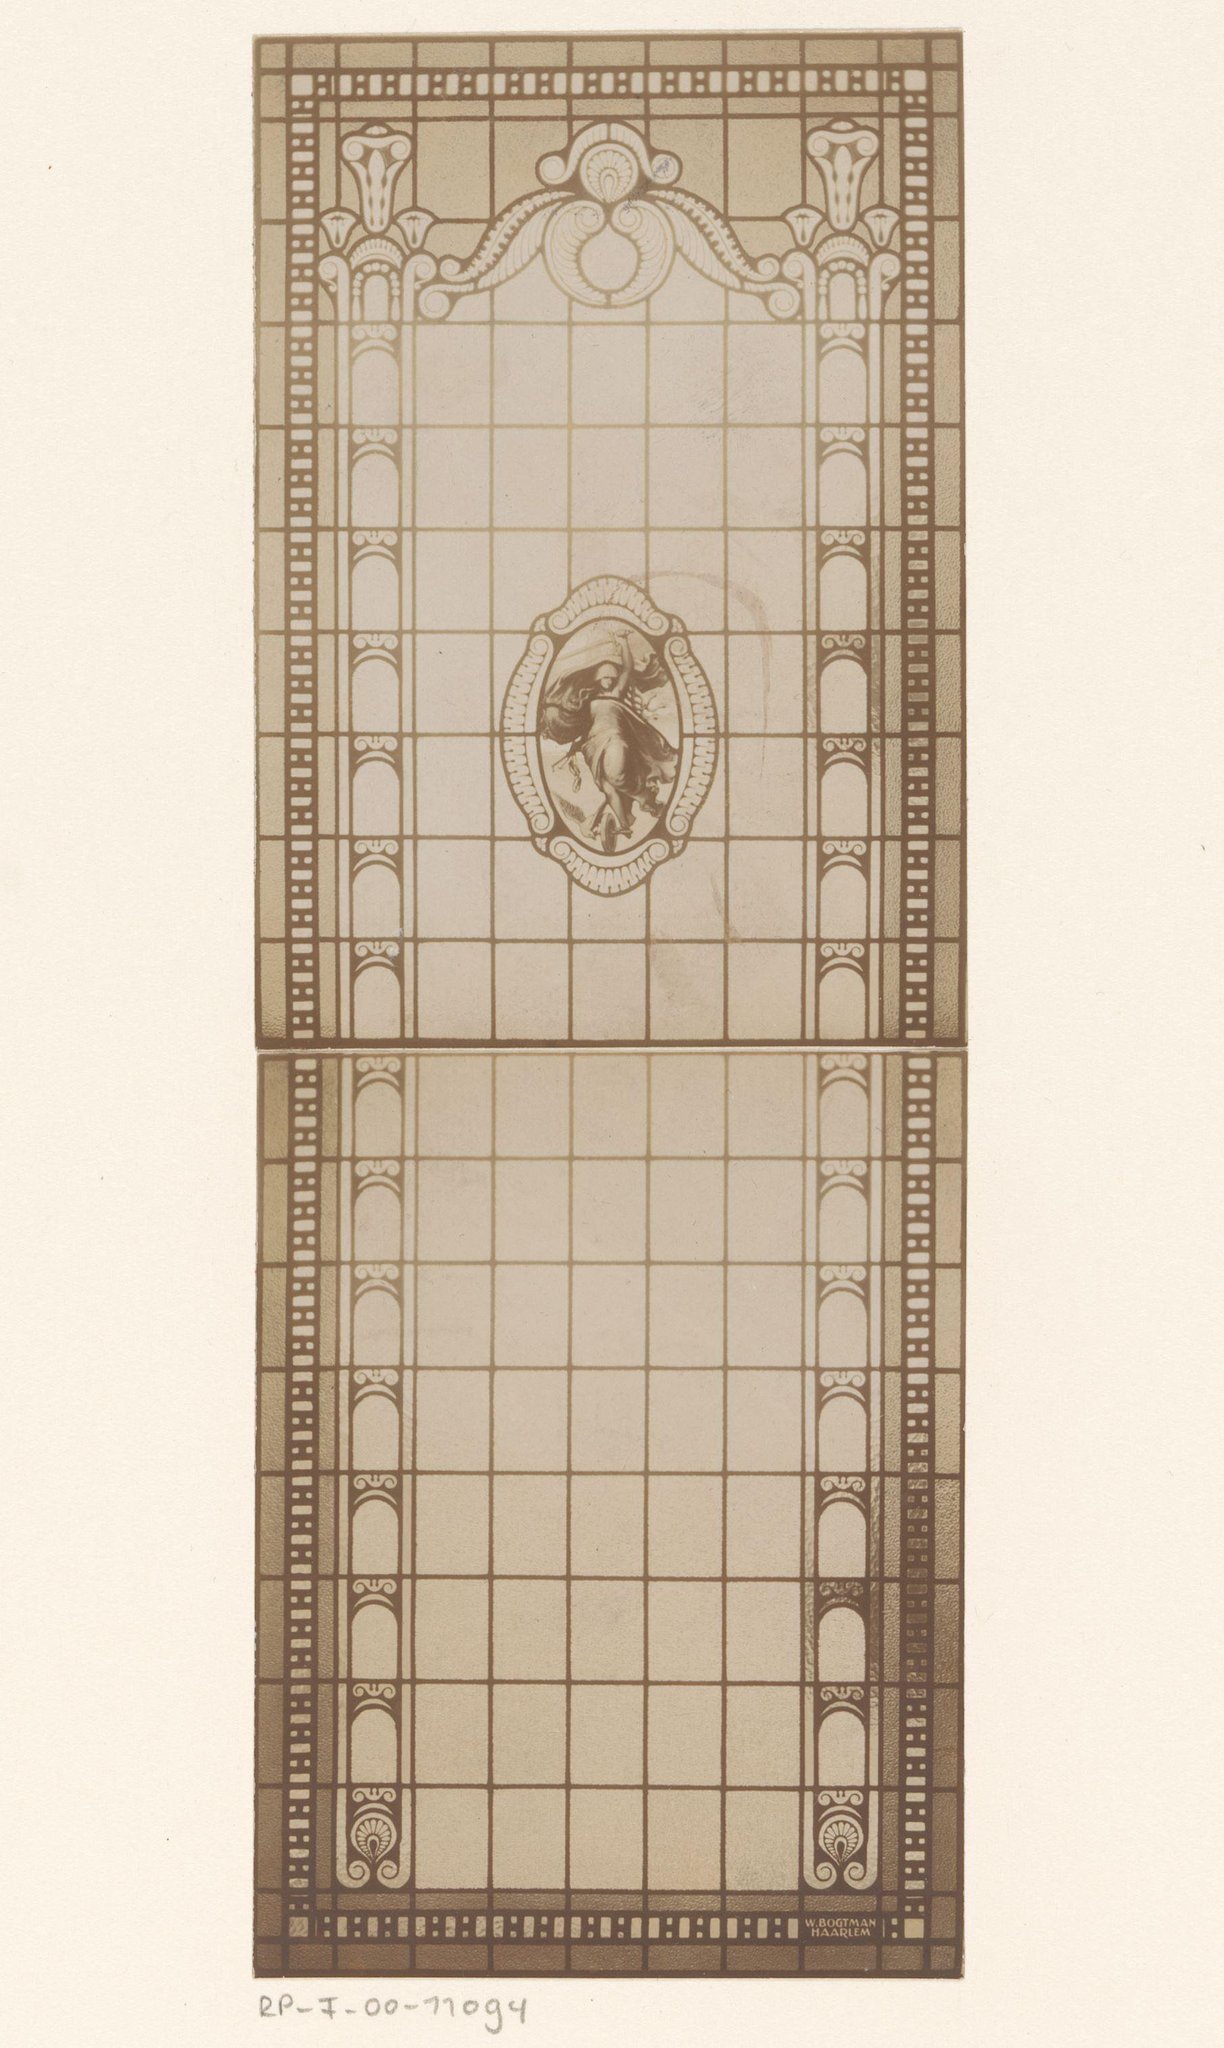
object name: photograph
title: Glas in loodraam van Willem Bogtman met een vrouwelijke personificatie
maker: Anonymous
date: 1907-1930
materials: photographic support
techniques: gelatin silver print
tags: work of monumental art